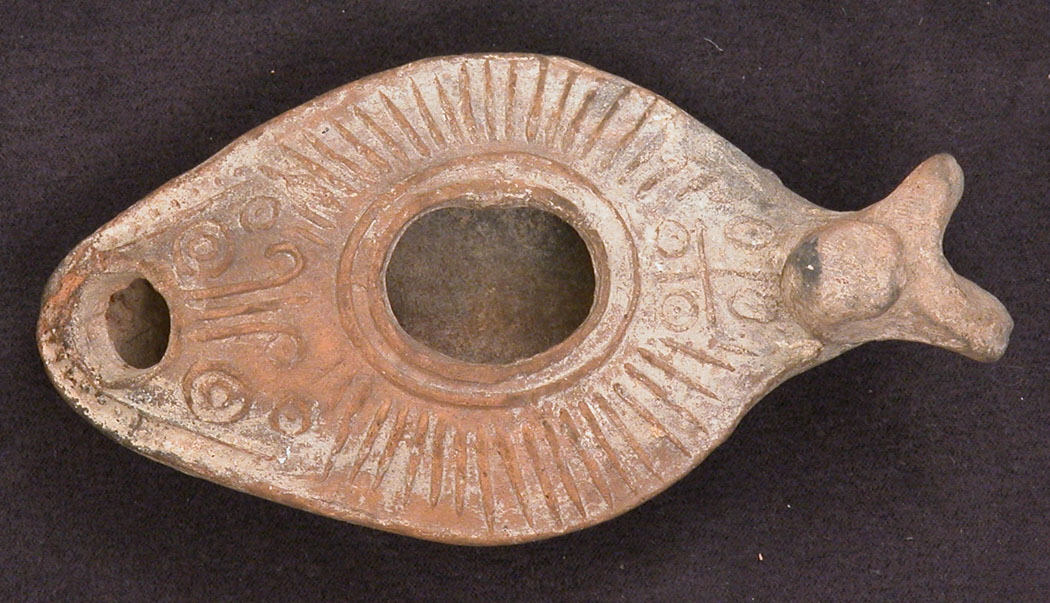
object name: lamp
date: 701-733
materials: earthenware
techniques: molding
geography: palestine